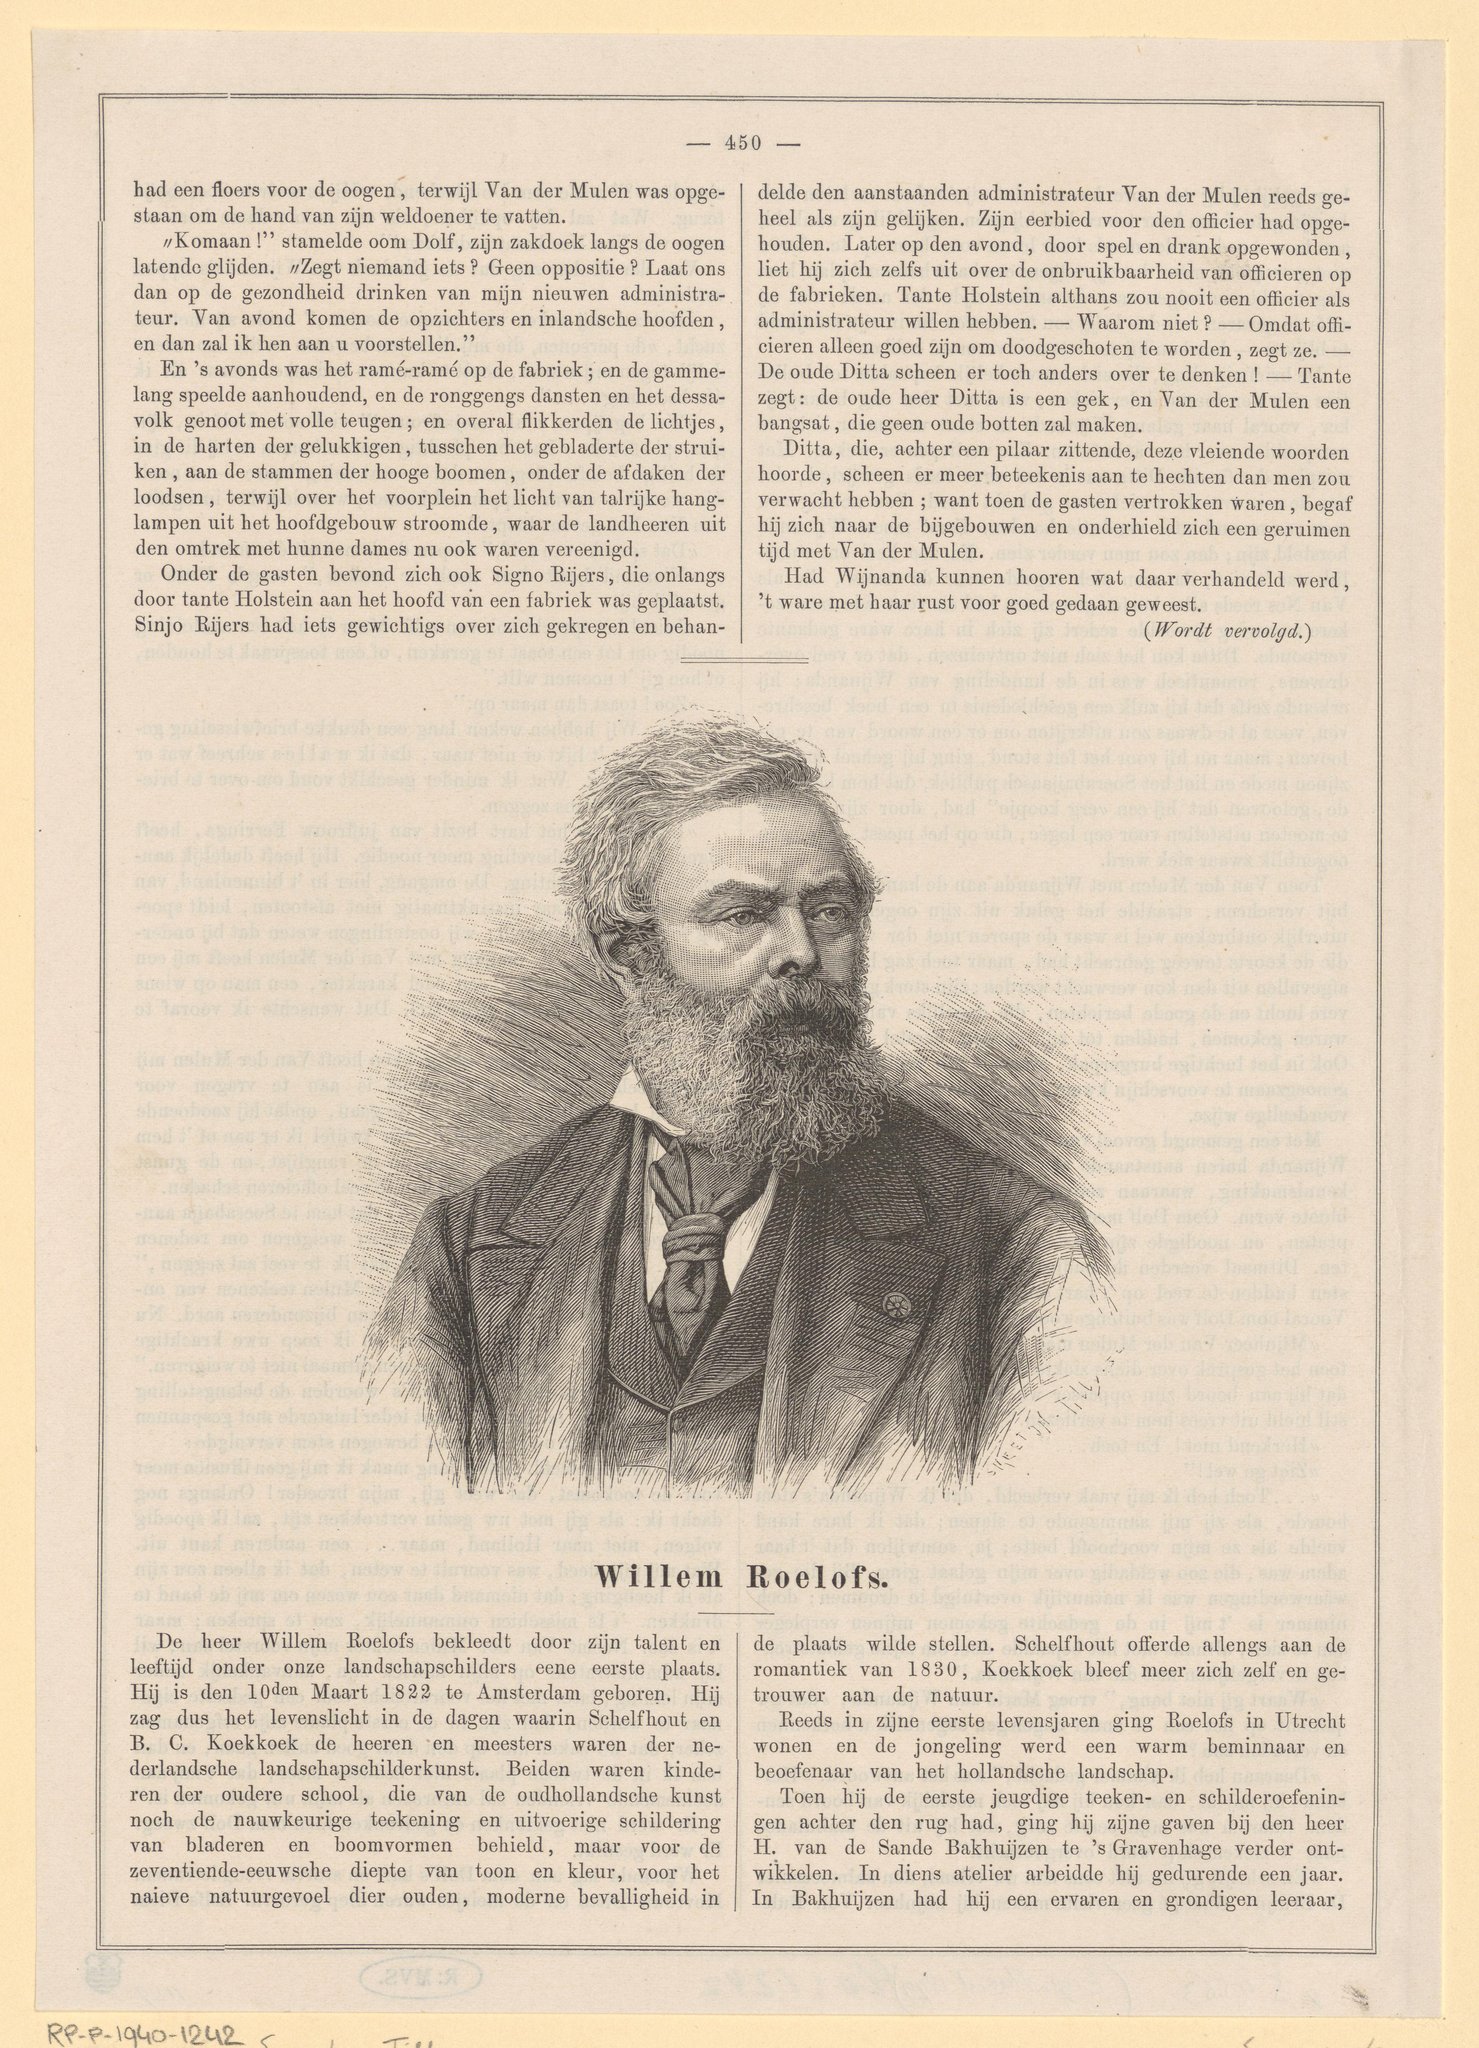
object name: print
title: Portret van Willem Roelofs I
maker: hermanus diedericus tjeenk willink (1843-1917)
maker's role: publisher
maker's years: 1843-1917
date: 1879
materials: paper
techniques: letterpress printing, engraving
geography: haarlem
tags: amsterdam, painter, print maker, draughtsman, willem roelofs (i), historical persons, portrait, self-portrait of painter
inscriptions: collector's mark: Lugt 2760, collector's mark: Lugt 2228